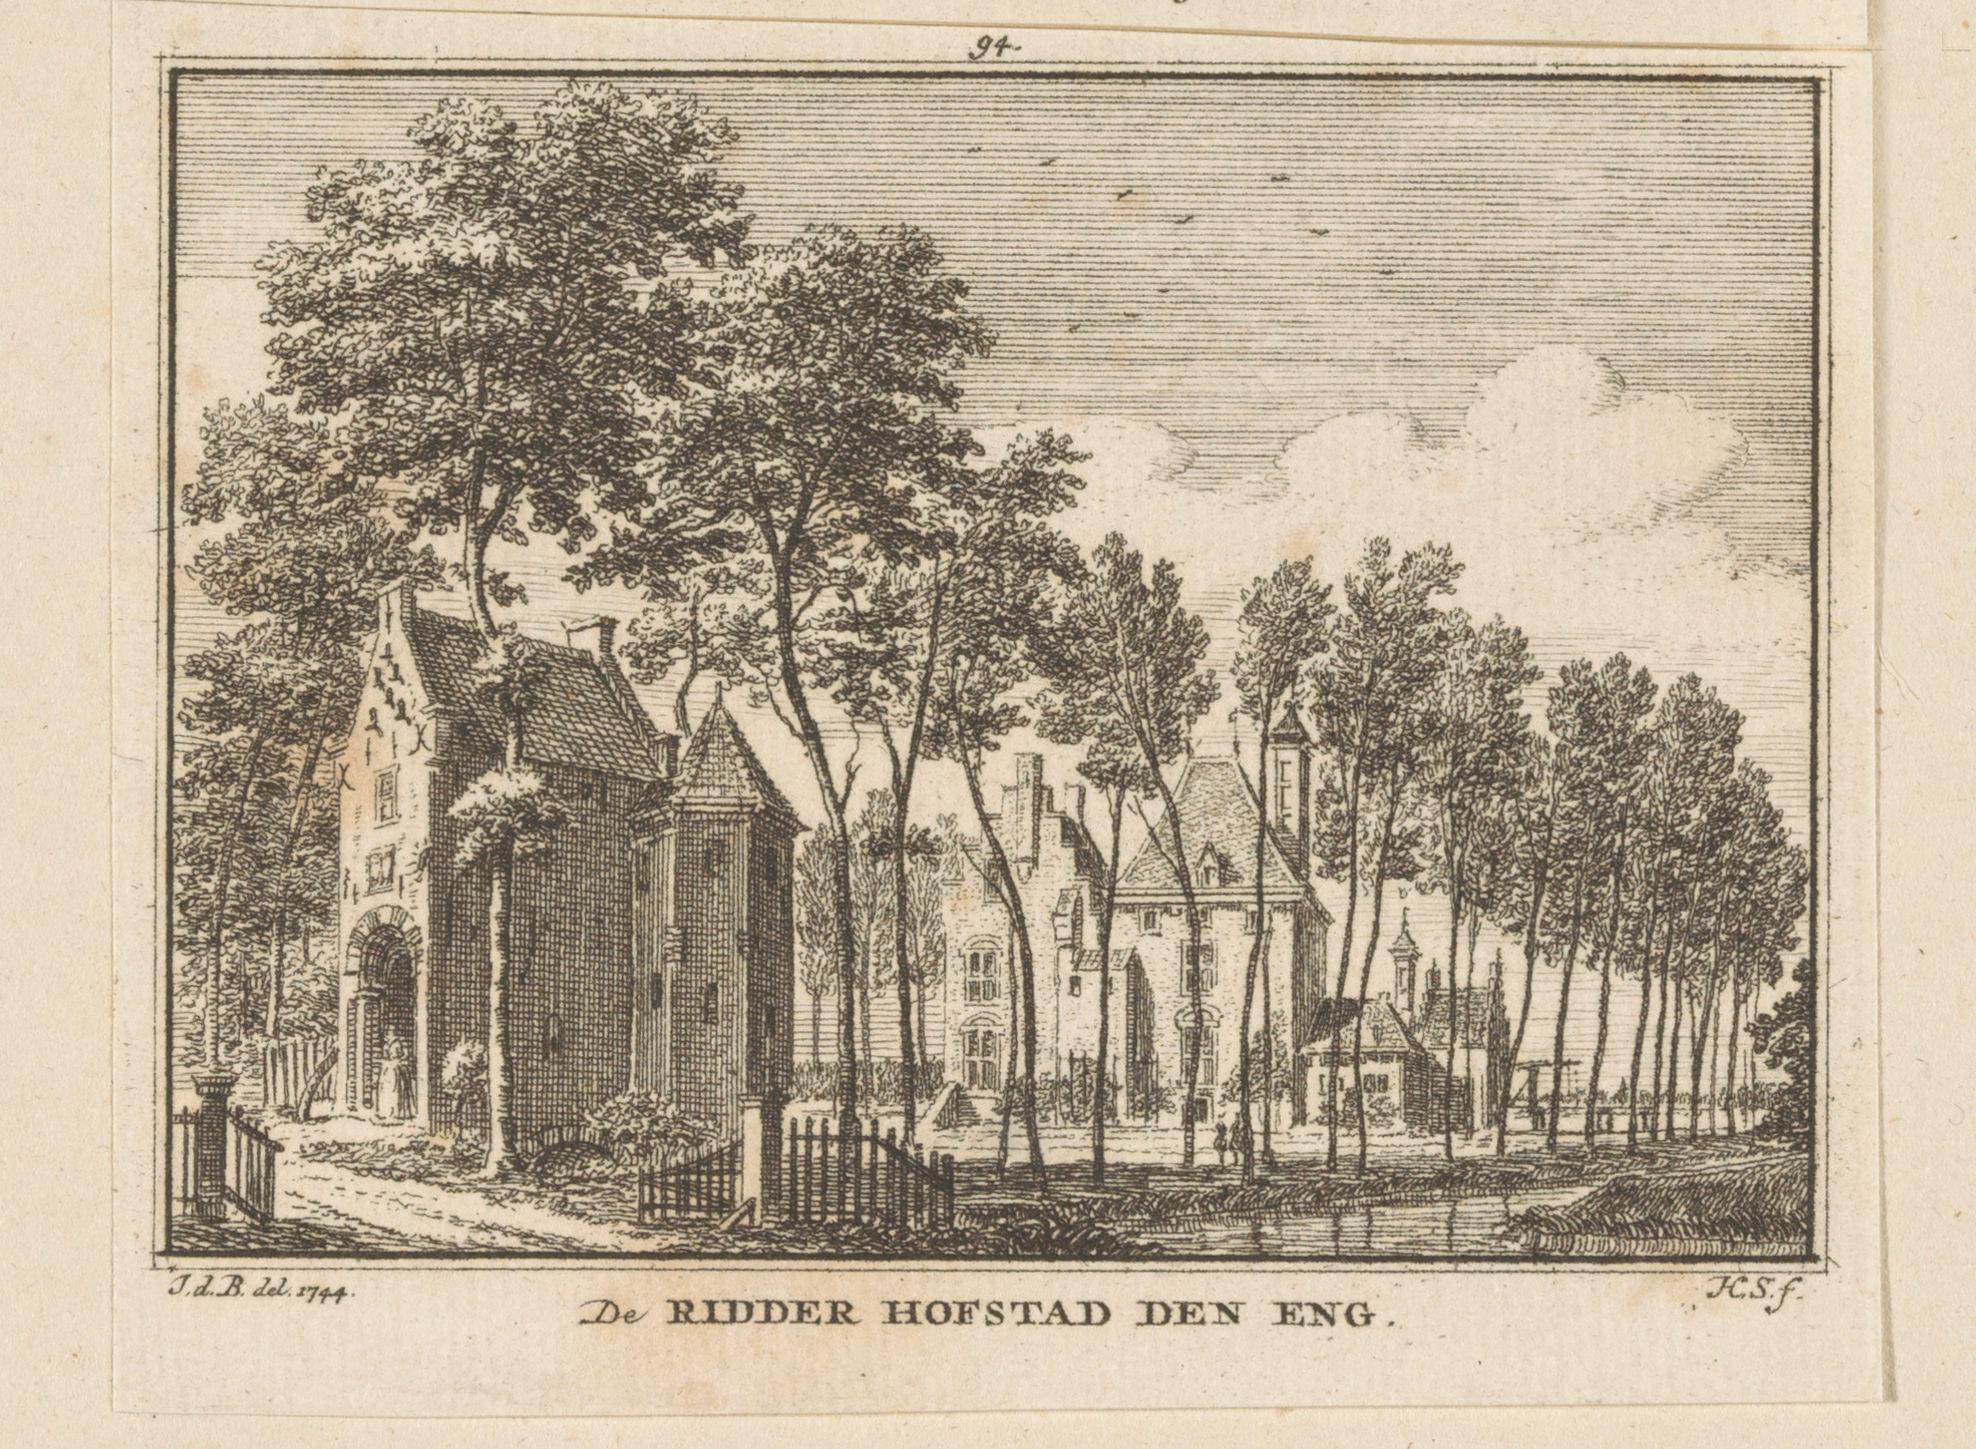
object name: print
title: De ridderhofstad Den Eng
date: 1773-1792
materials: paper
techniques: engraving, etching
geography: haarlem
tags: castle, gate, entrance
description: Prent ook gebruikt in: Het verheerlykt Nederland of kabinet van hedendaagsche gezigten van steden, dorpen (…). 9 delen. Amsterdam: Isaak Tirion en weduwe Isaak Tirion, 1745-1774, dl. 7, 8 of 9 (weduwe Isaak Tirion, 1773-1774), ill. 94. Of in: Nederlandsche tafereelen; of eene keurige verzameling van negen honderd fraaije gezigten van steden, dorpen, sloten, oudheden (….). 9 delen. Amsterdam: Jan de Groot, 1792, dl. 7, 8 of 9, ill. 94. Uit welke druk het huidige exemplaar precies komt is niet na te gaan.